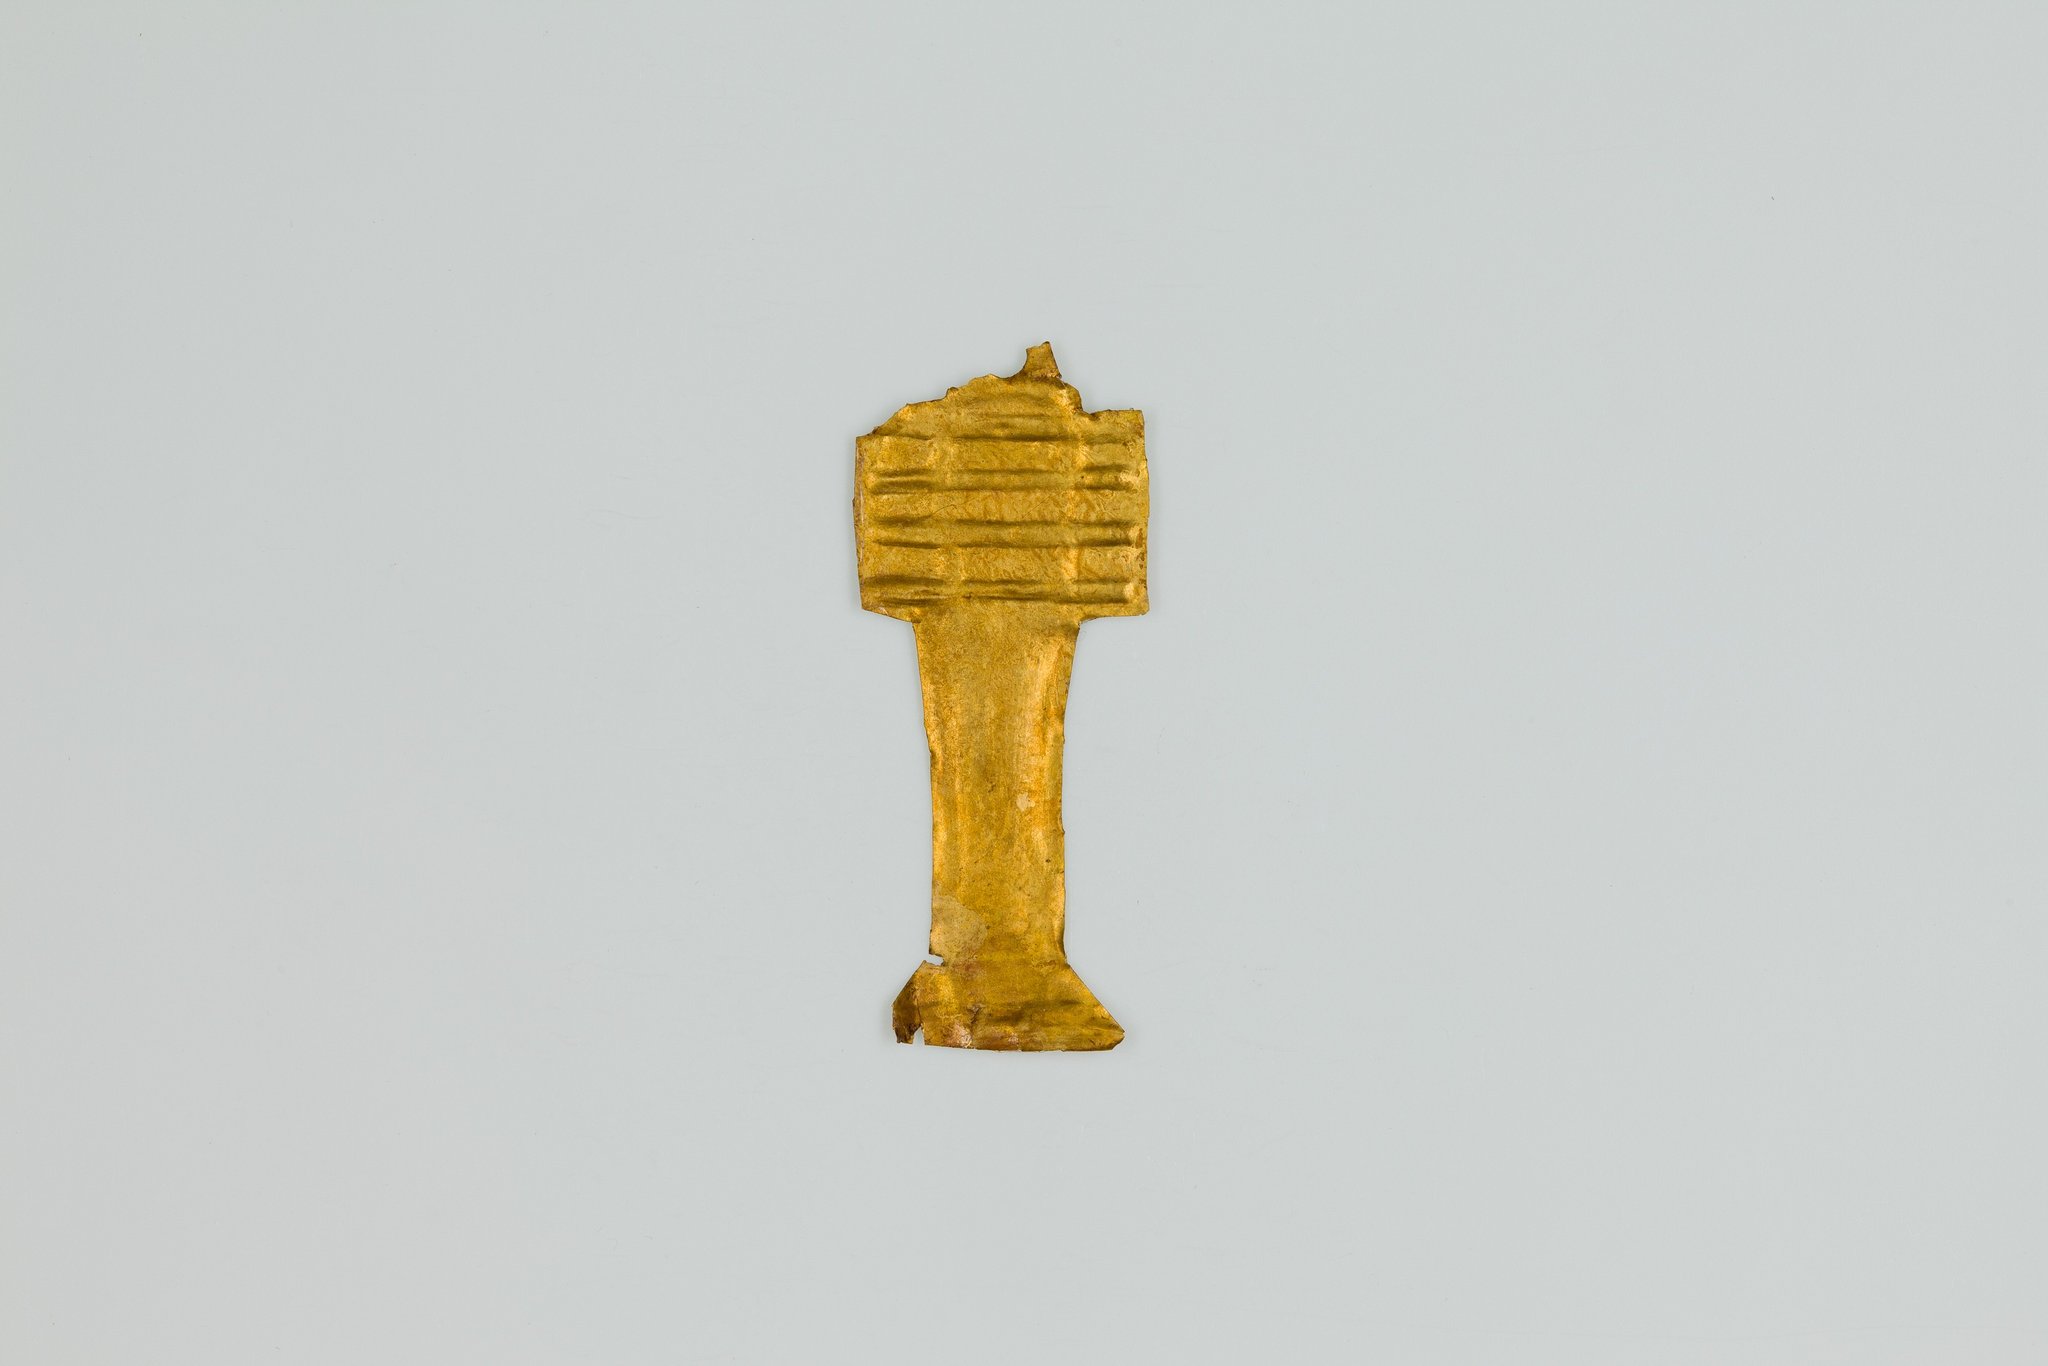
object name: amulet, djed pillar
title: Djed pillar amulet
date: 664-380 BCE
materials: gold